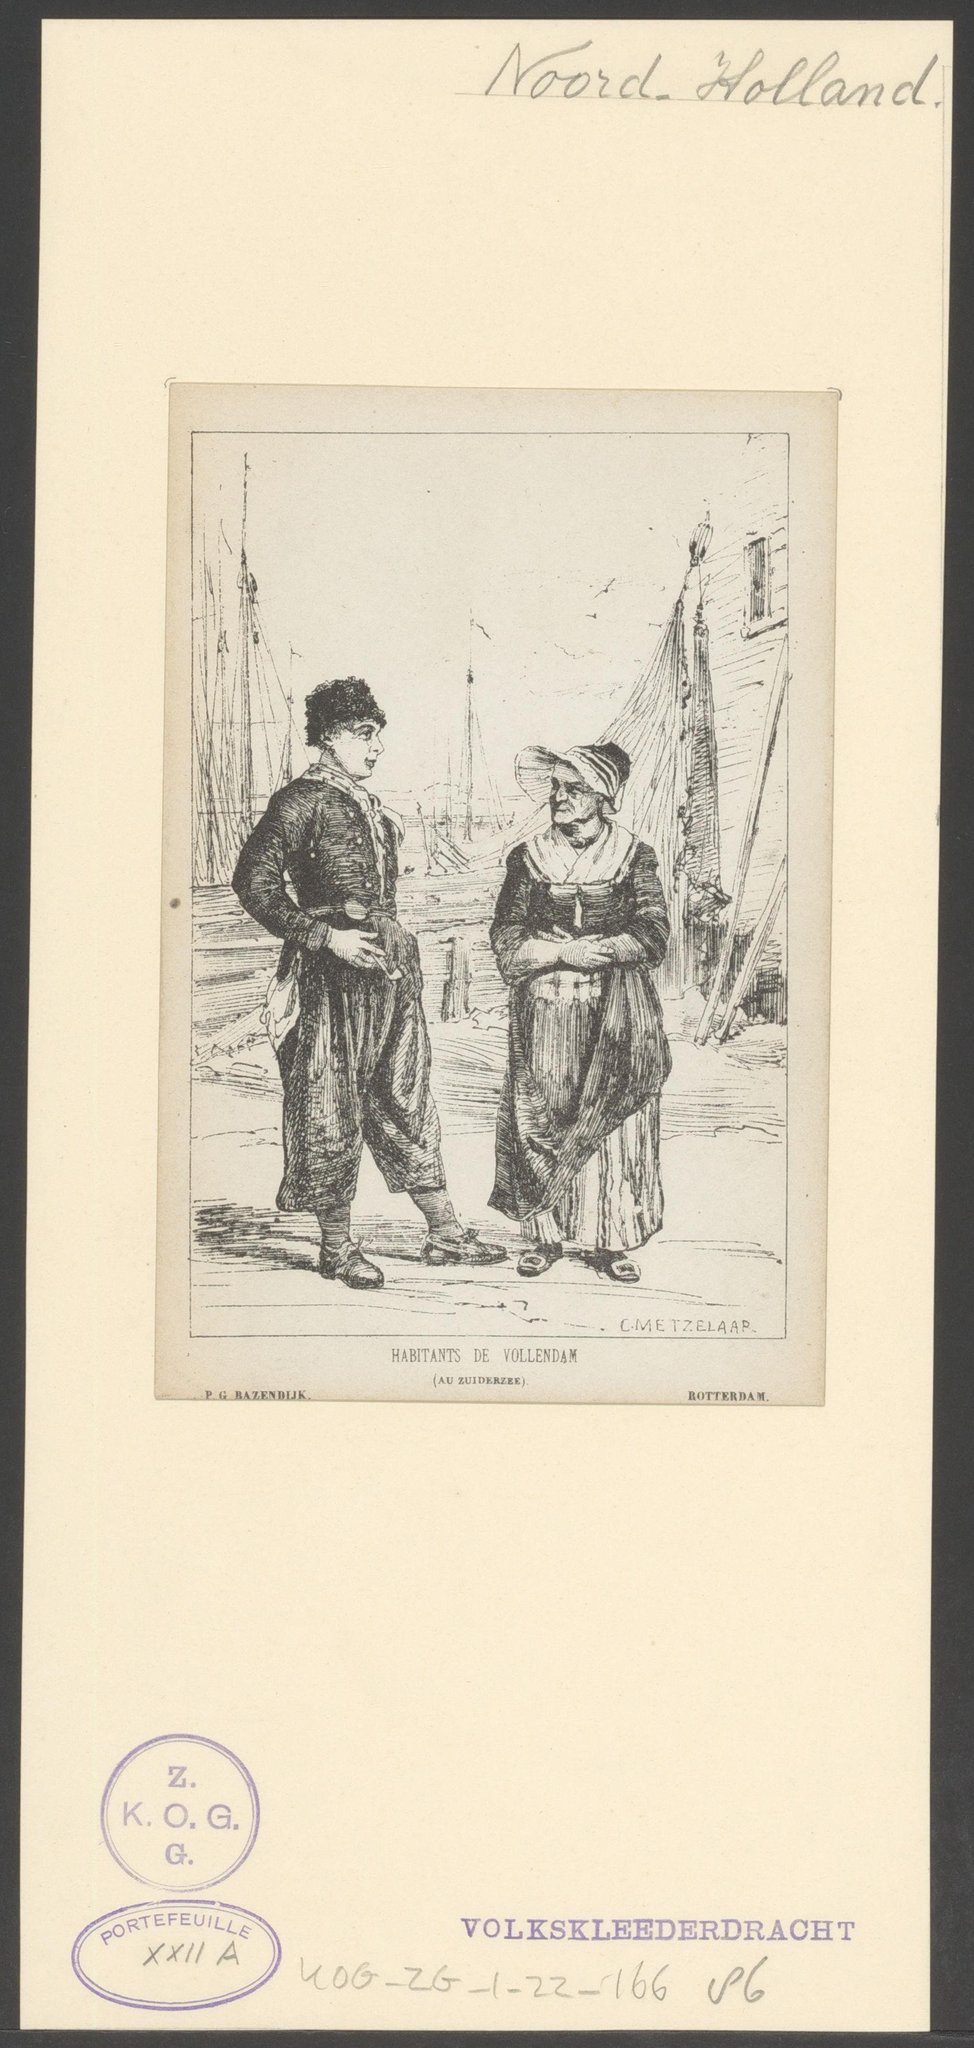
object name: print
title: Habitants de Vollendam. (Au Zuiderzee)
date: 1855-1881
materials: paper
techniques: lithograph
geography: rotterdam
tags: sea and coastal fishery (+ men (labourers)), clothes, costume (+ women's clothes), clothes, costume (+ men's clothes), folk costume, regional costume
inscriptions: collector's mark: Lugt 1641, collector's mark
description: Inwoners van Volendam. Onderwerpsrubrieken binnen de Atlas Zeden en Gewoonten: De Kleeding, Volkskleederdracht, Noord-Holland.